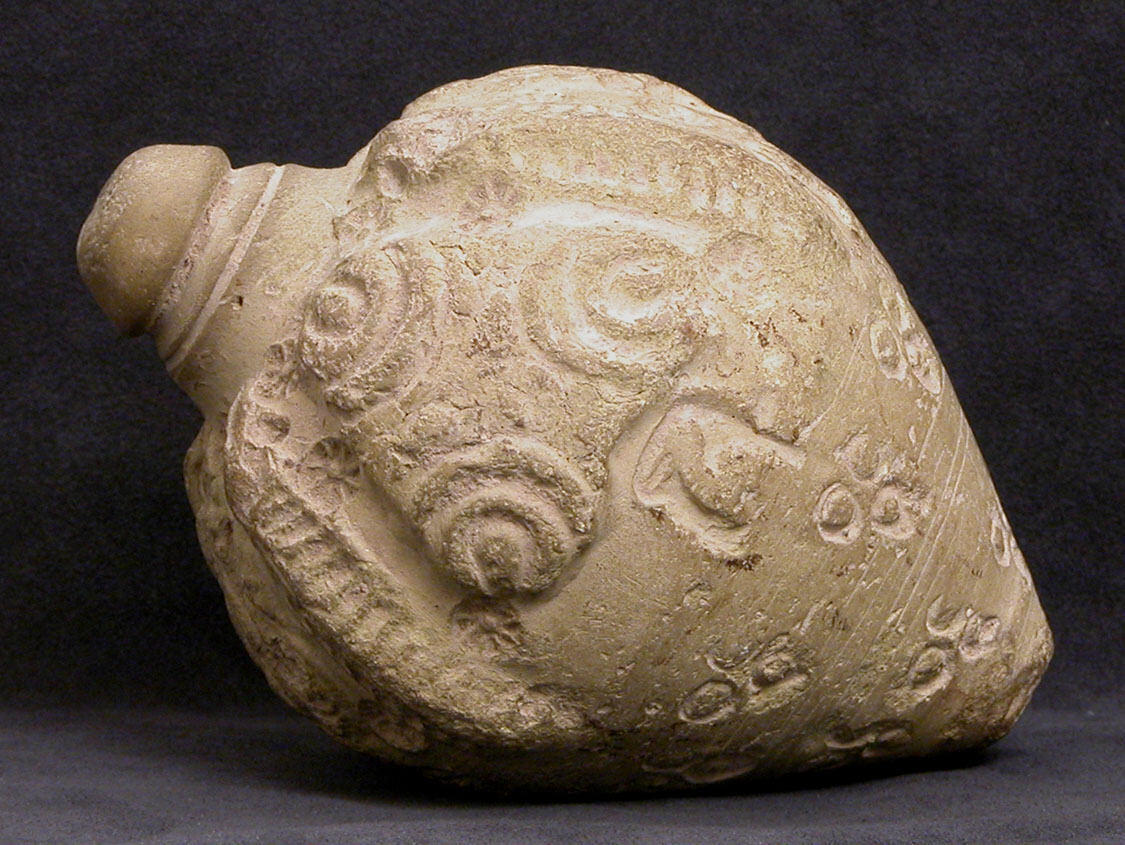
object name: vessel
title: Spheroconical Vessel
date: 901-1100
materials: earthenware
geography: iran